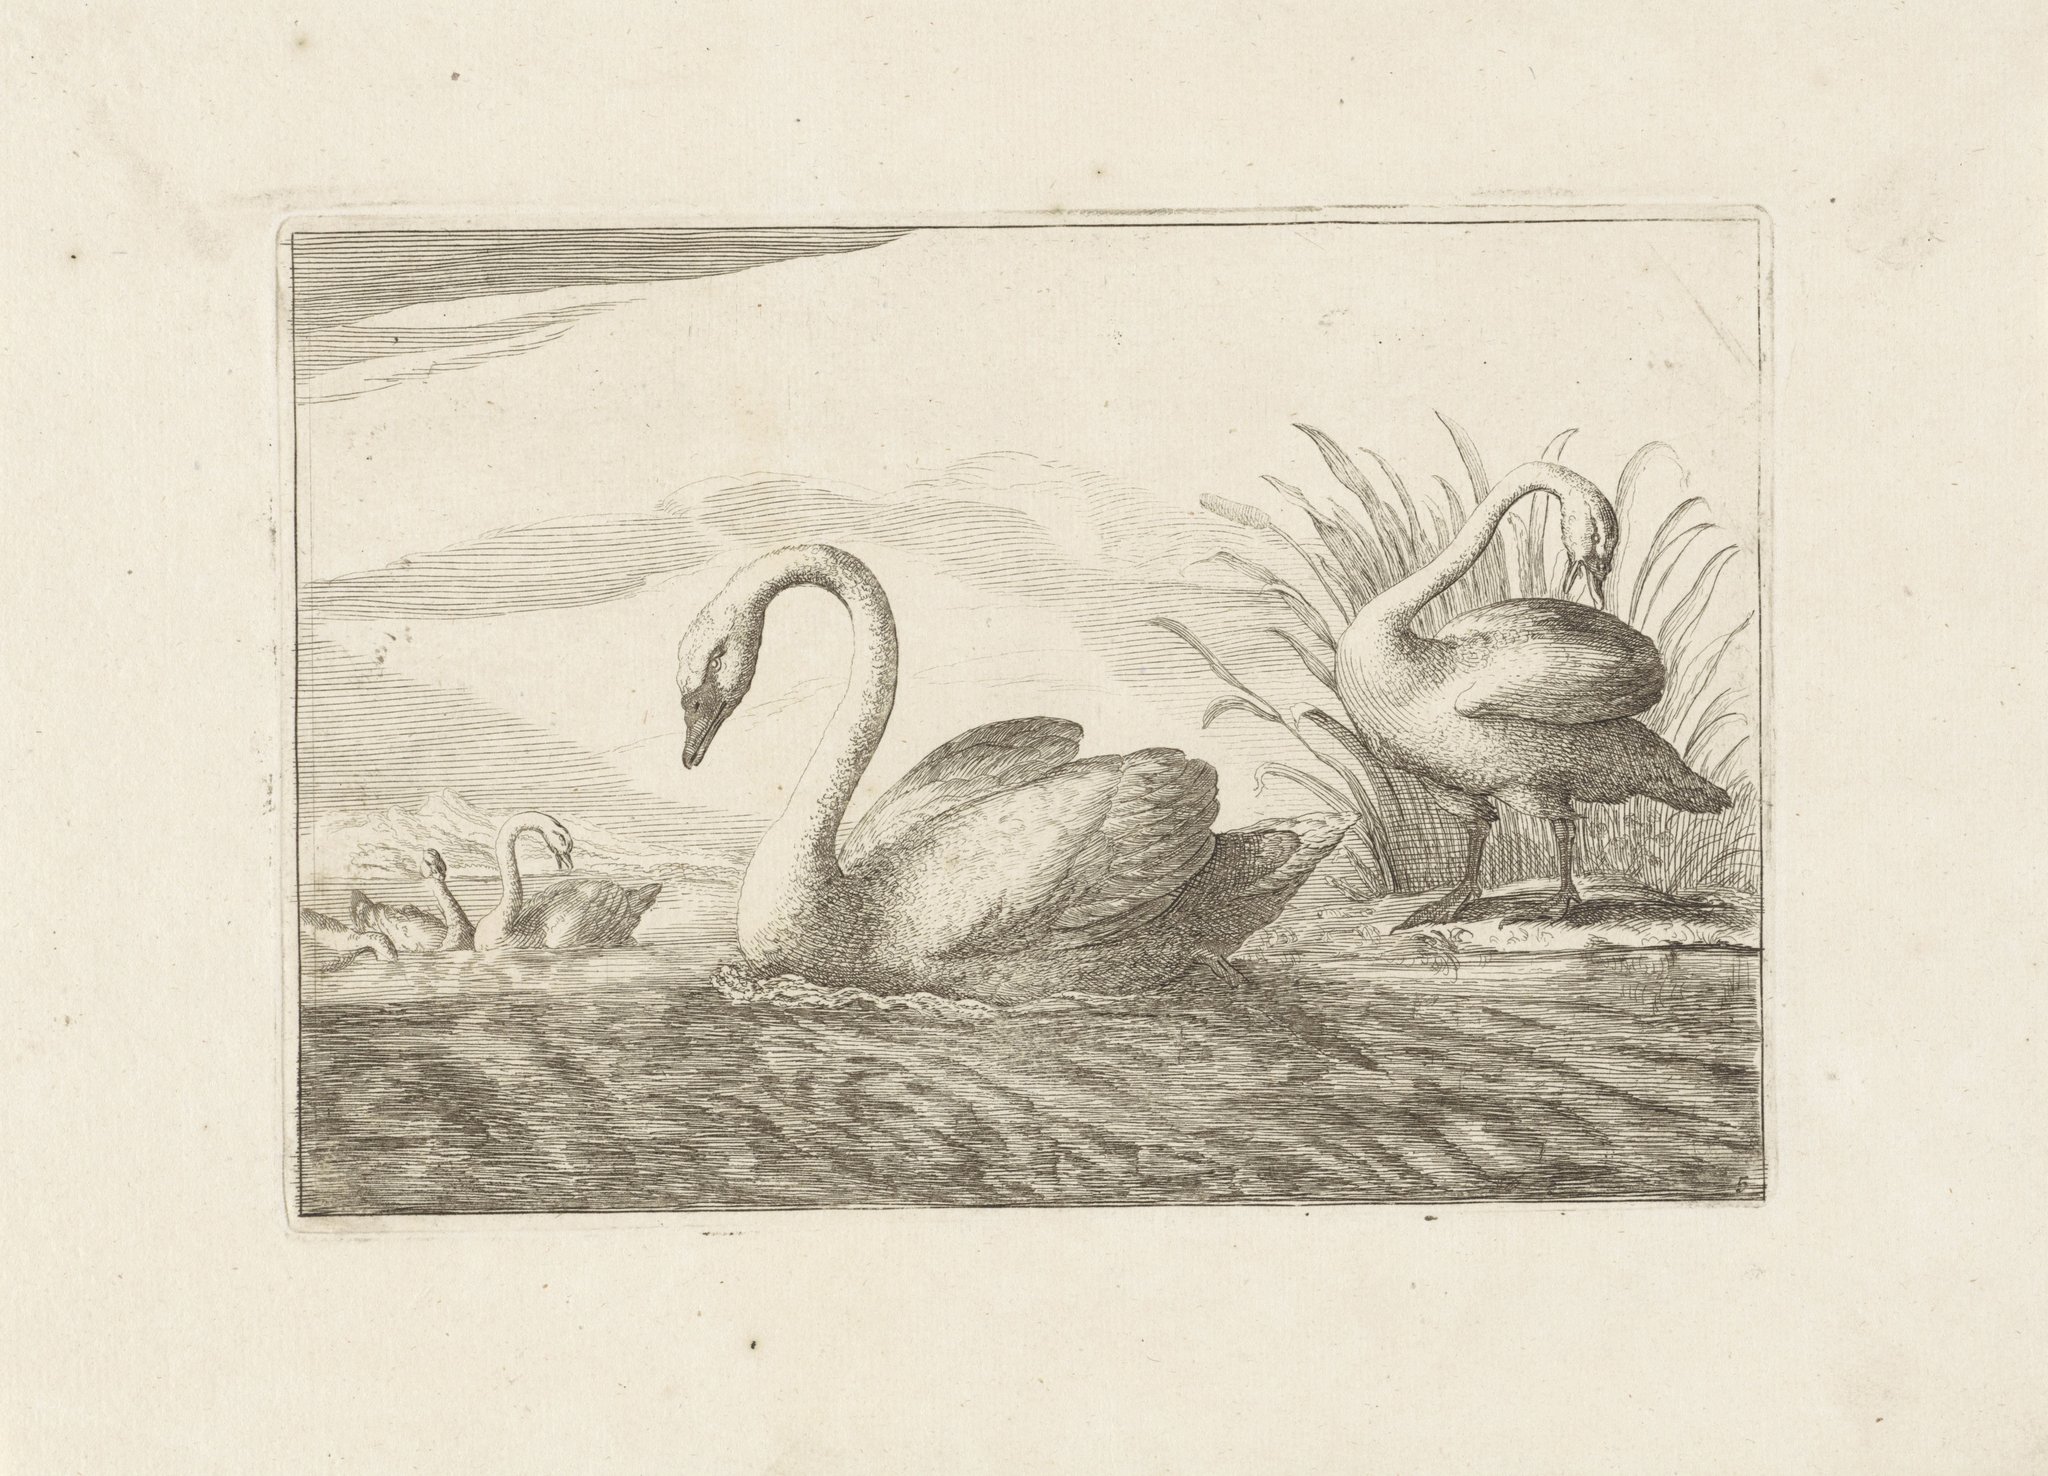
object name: print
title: Verschillende vogels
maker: pieter schenk (i)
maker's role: print maker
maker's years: 1660-1711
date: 1675-1711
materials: paper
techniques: etching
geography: amsterdam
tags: water-birds: swan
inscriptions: collector's mark: Lugt 2228